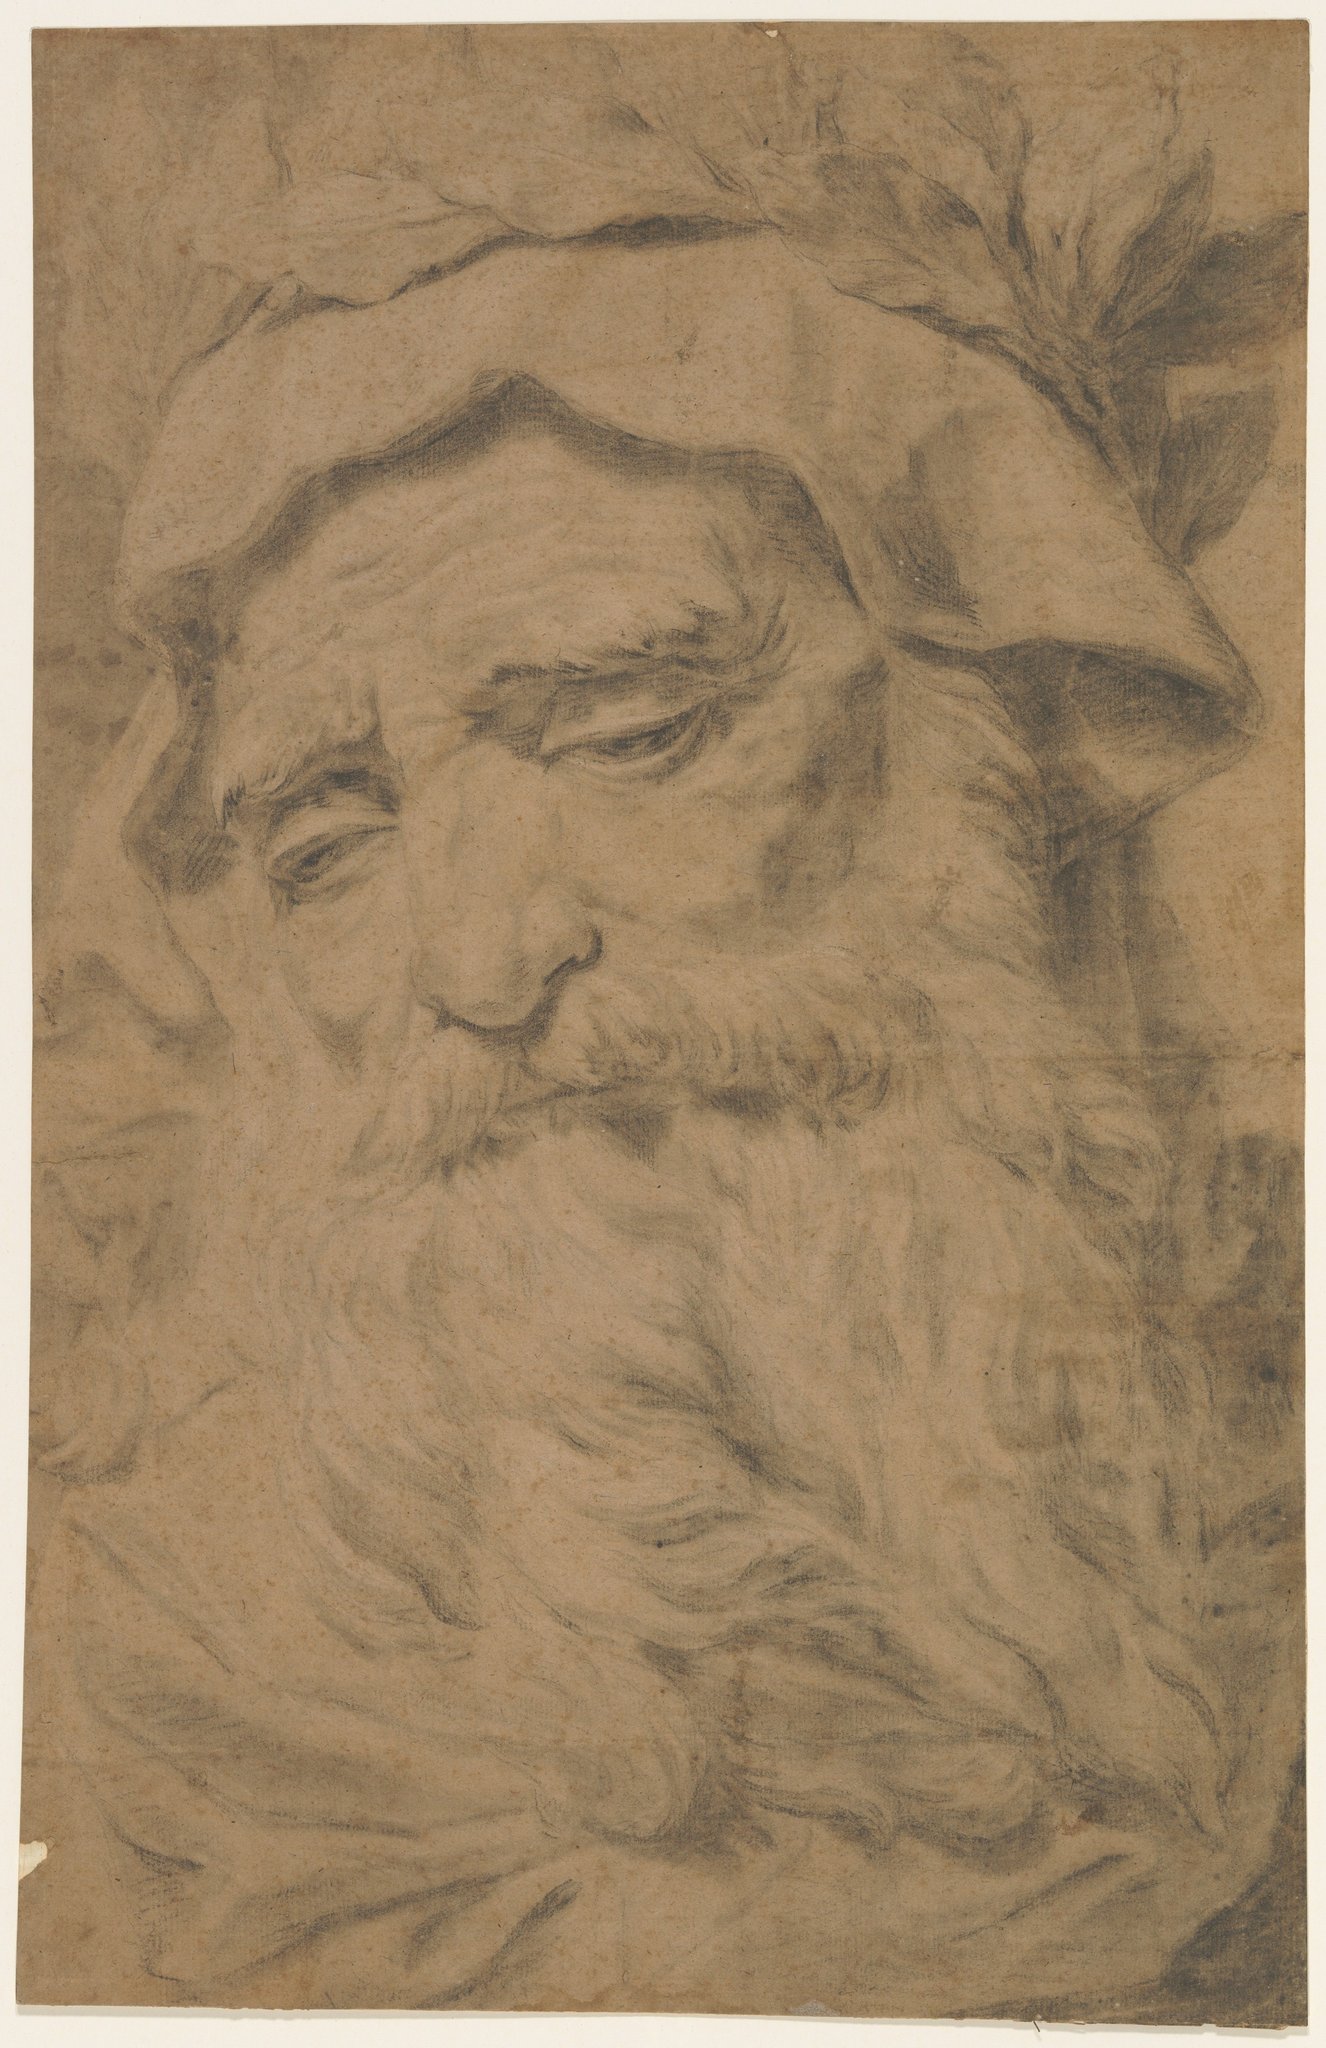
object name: drawing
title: Head of a Bearded Old Man Wearing a Laurel Crown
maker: antoine françois callet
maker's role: artist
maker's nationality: french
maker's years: 1741-1823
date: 1734-1833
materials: chalk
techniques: heightening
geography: france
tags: men